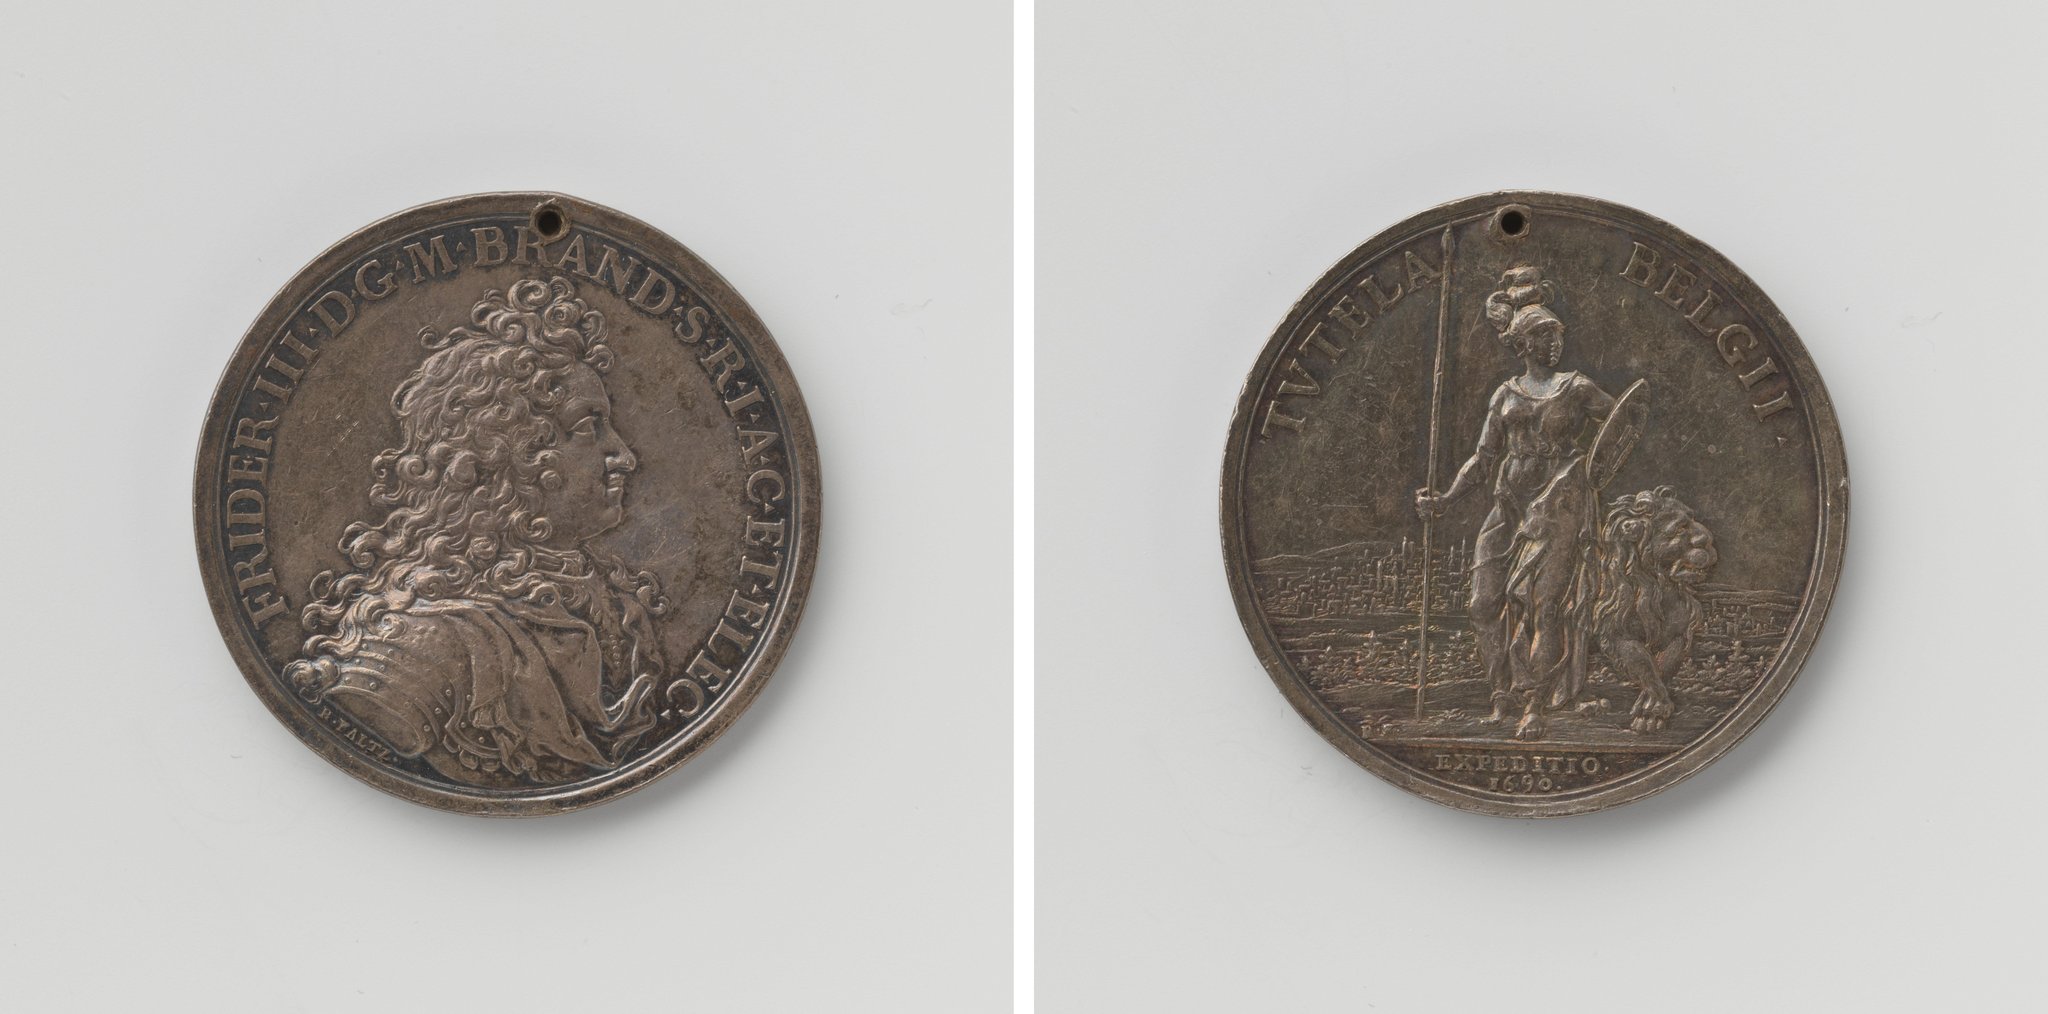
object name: history medal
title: Tocht van Frederik III, keurvorst van Brandenburg naar de Spaanse Nederlanden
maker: raimund faltz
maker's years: 1658-1703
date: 1690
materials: silver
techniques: striking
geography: berlin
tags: berlin, frederik i koning van pruisen, southern netherlands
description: Zilveren penning met gat erin. Voorzijde: borststuk man binnen omschrift. Keerzijde: Pallas Athena met helm, speer en schild beschermt Nederlandse leeuw binnen omschrift; afsnede: opschrift